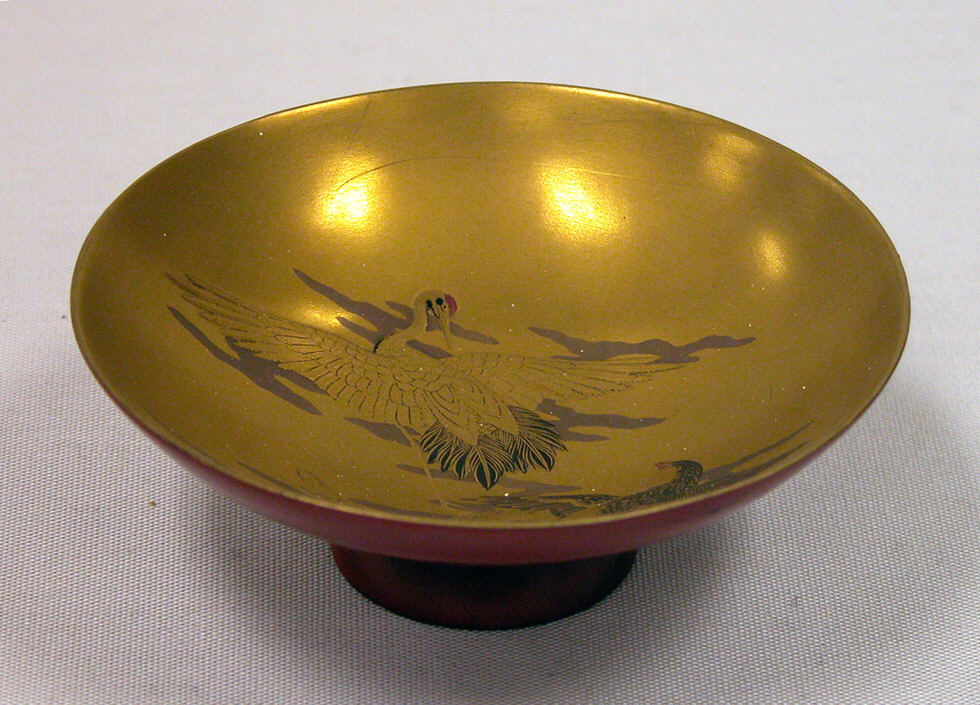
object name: wine cup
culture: japanese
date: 1867-1900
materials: gold, lacquer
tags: birds